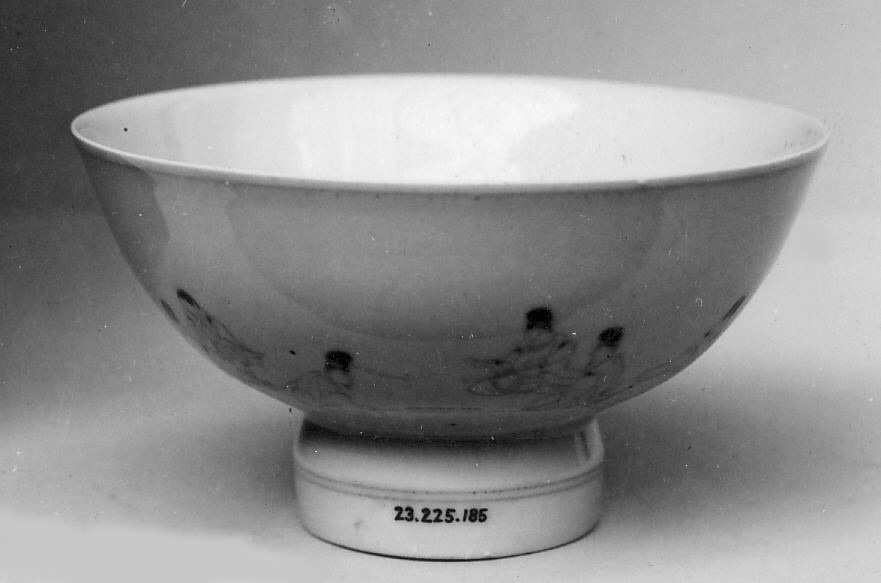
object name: cup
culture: japanese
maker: maekawa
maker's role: artist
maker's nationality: japanese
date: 1820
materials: glaze, porcelain